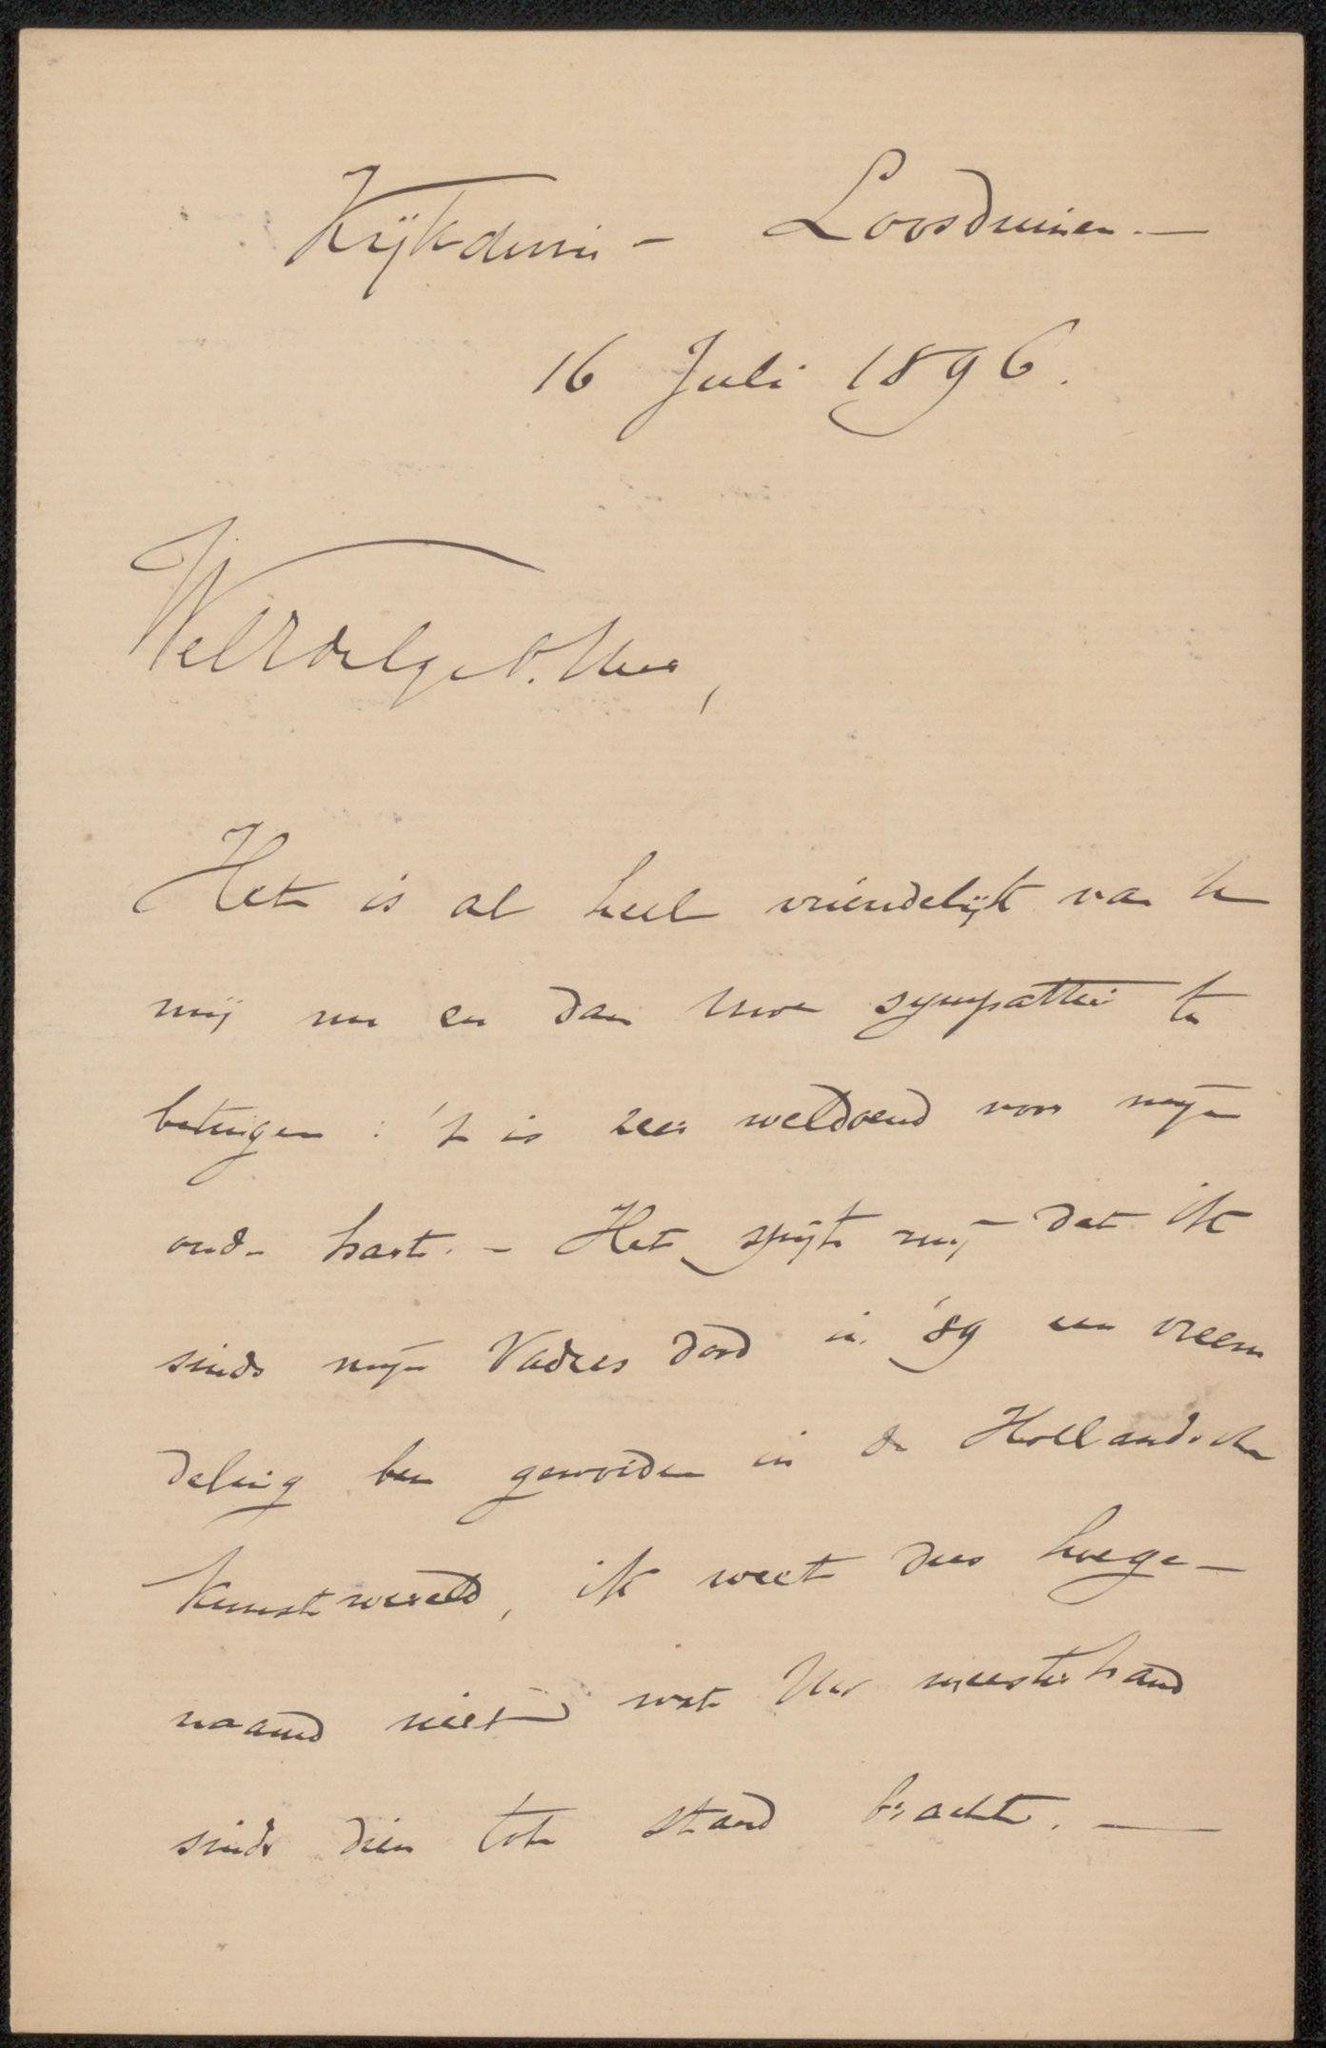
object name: letter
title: Brief aan Philip Zilcken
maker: catharina alberdingk thijm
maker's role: schrijver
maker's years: 1848-1908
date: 1896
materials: ink, paper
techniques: pen, writing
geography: kijkduin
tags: amsterdam, publisher, josephus albertus alberdingk thijm, the hague, painter, draughtsman, philip zilcken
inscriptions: collector's mark: ‘RPK’